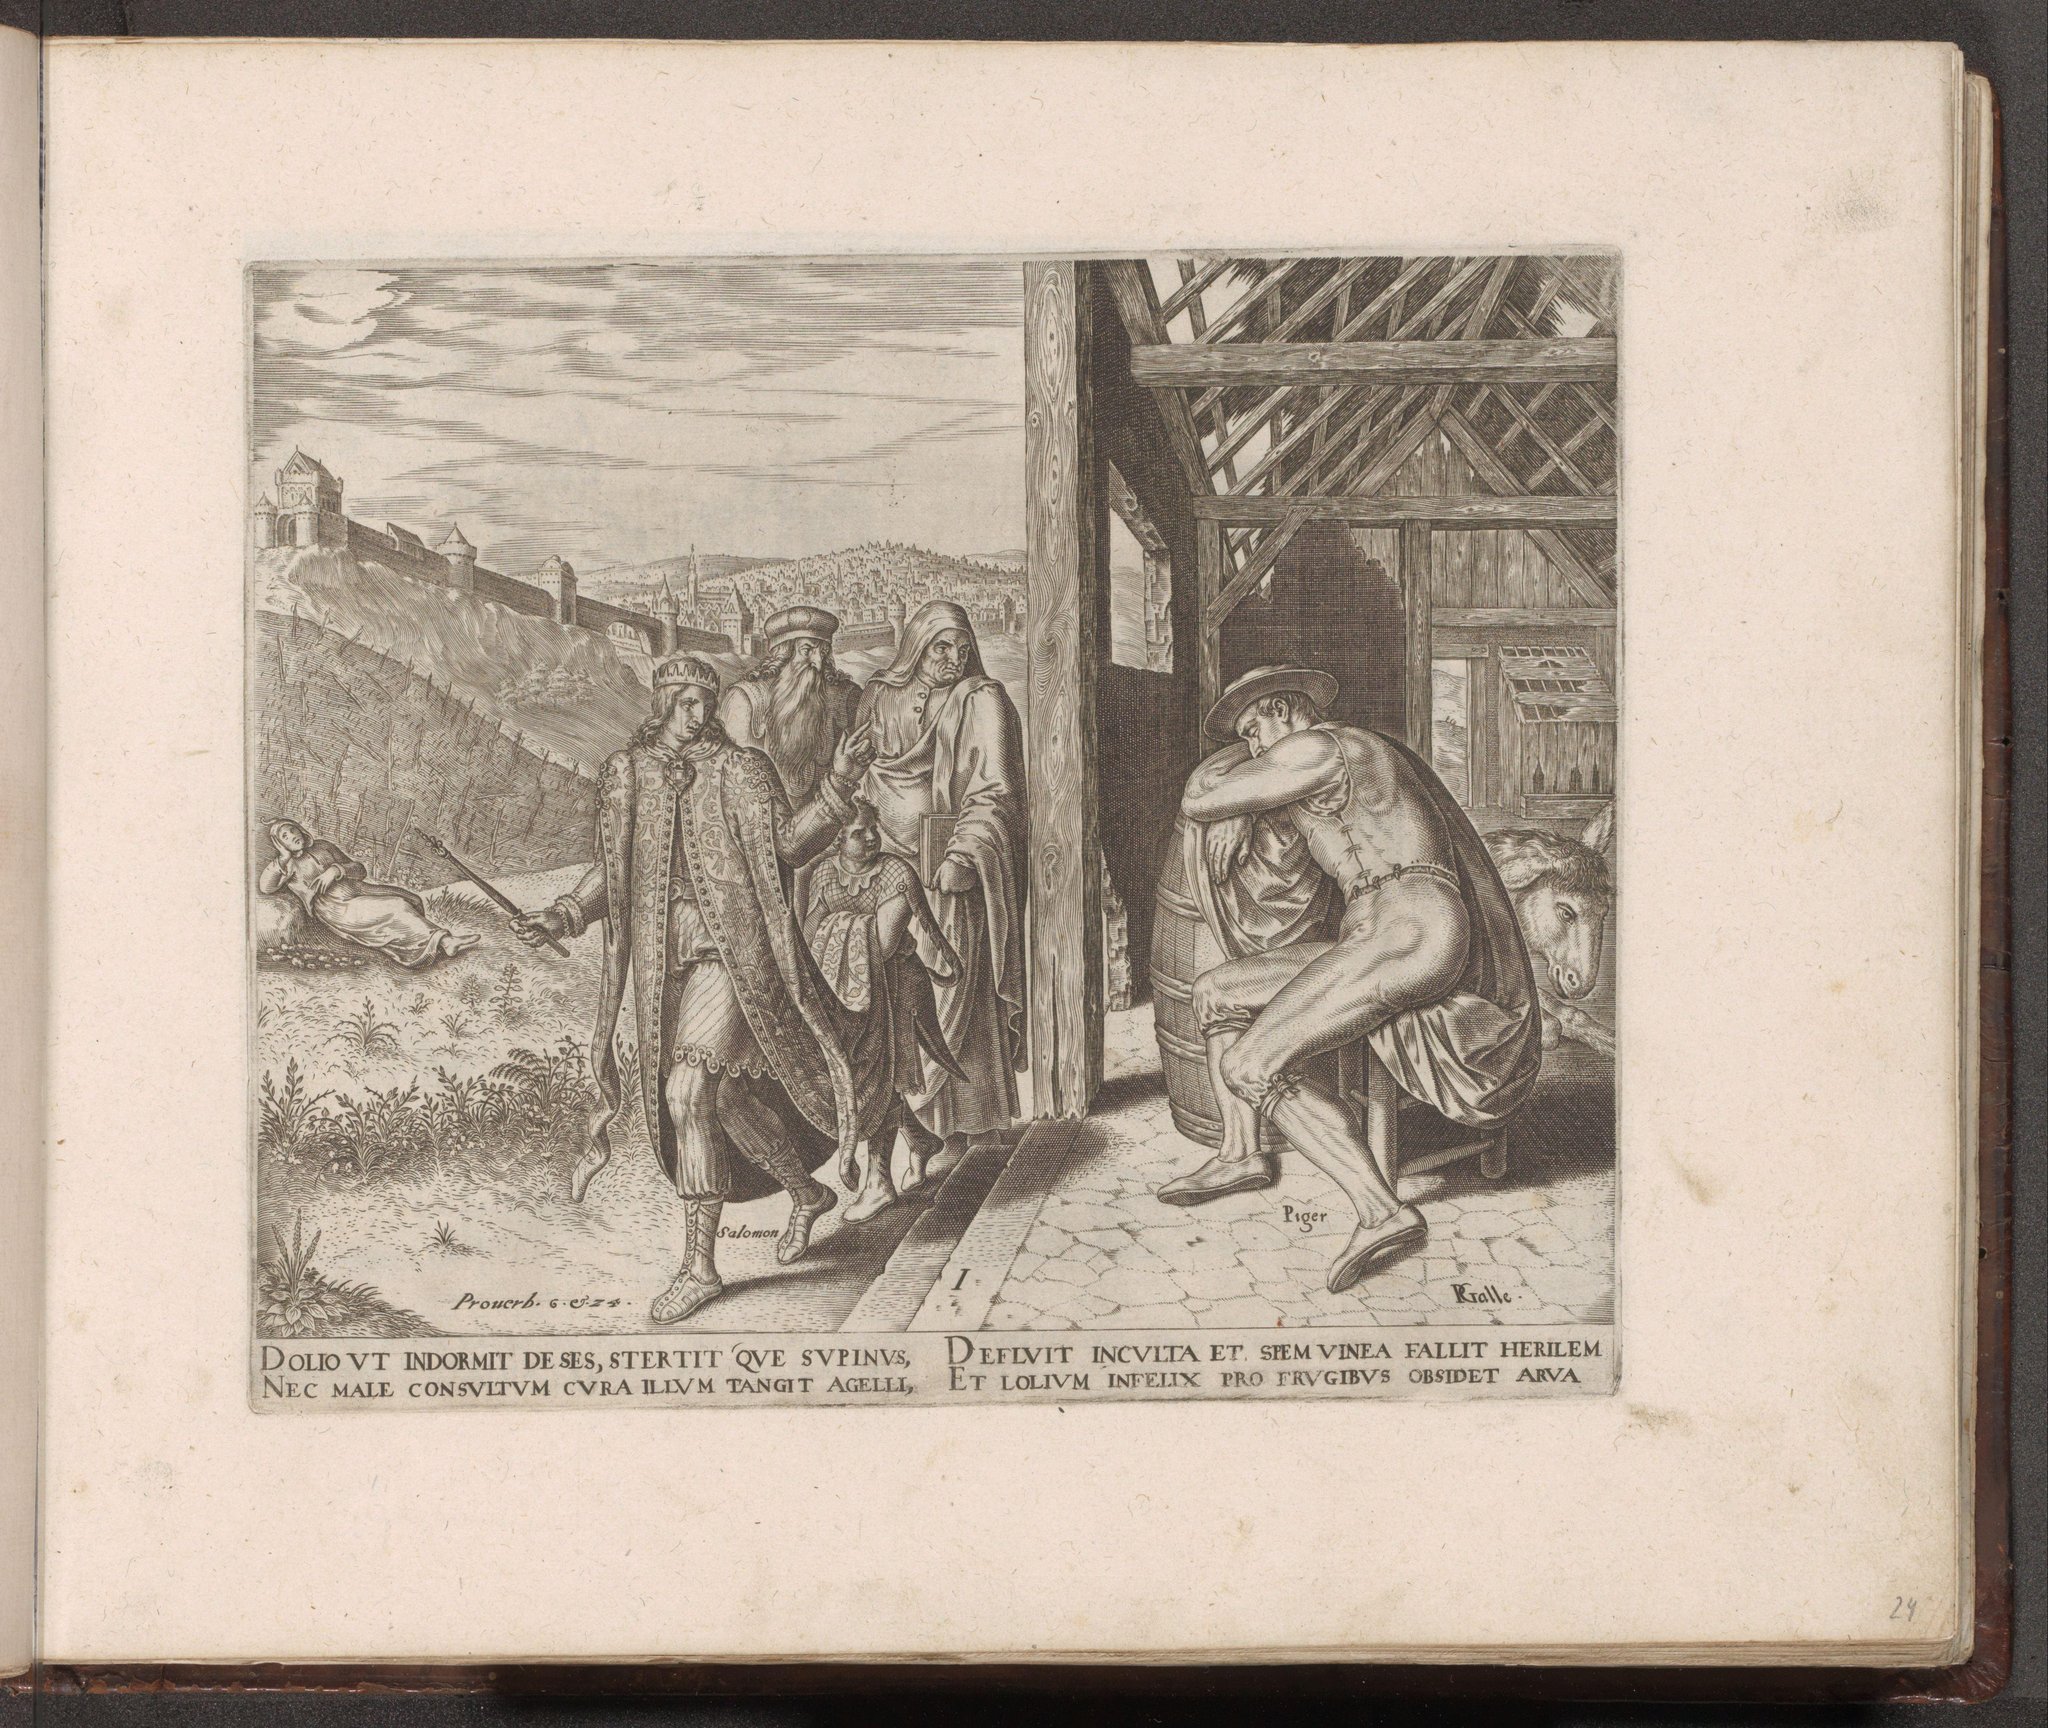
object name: album leaf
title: Verhaal van de luiaard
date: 1563-1567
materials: paper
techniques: engraving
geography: haarlem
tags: the book of proverbs, sluggard, solomon as teacher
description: Koning Salomo loopt door een wijngaard en wijst zijn gezelschap op een luiaard die op klaarlichte dag in een stal slaapt, terwijl zijn wijngaard vergaat. Een tweede luiaard ligt in het veld te slapen. Naar de Bijbelteksten in Spr. 6:9 en Spr. 24:30-31. Onder de voorstelling een verklarende tekst in het Latijn. Prent maakt deel uit van een album.